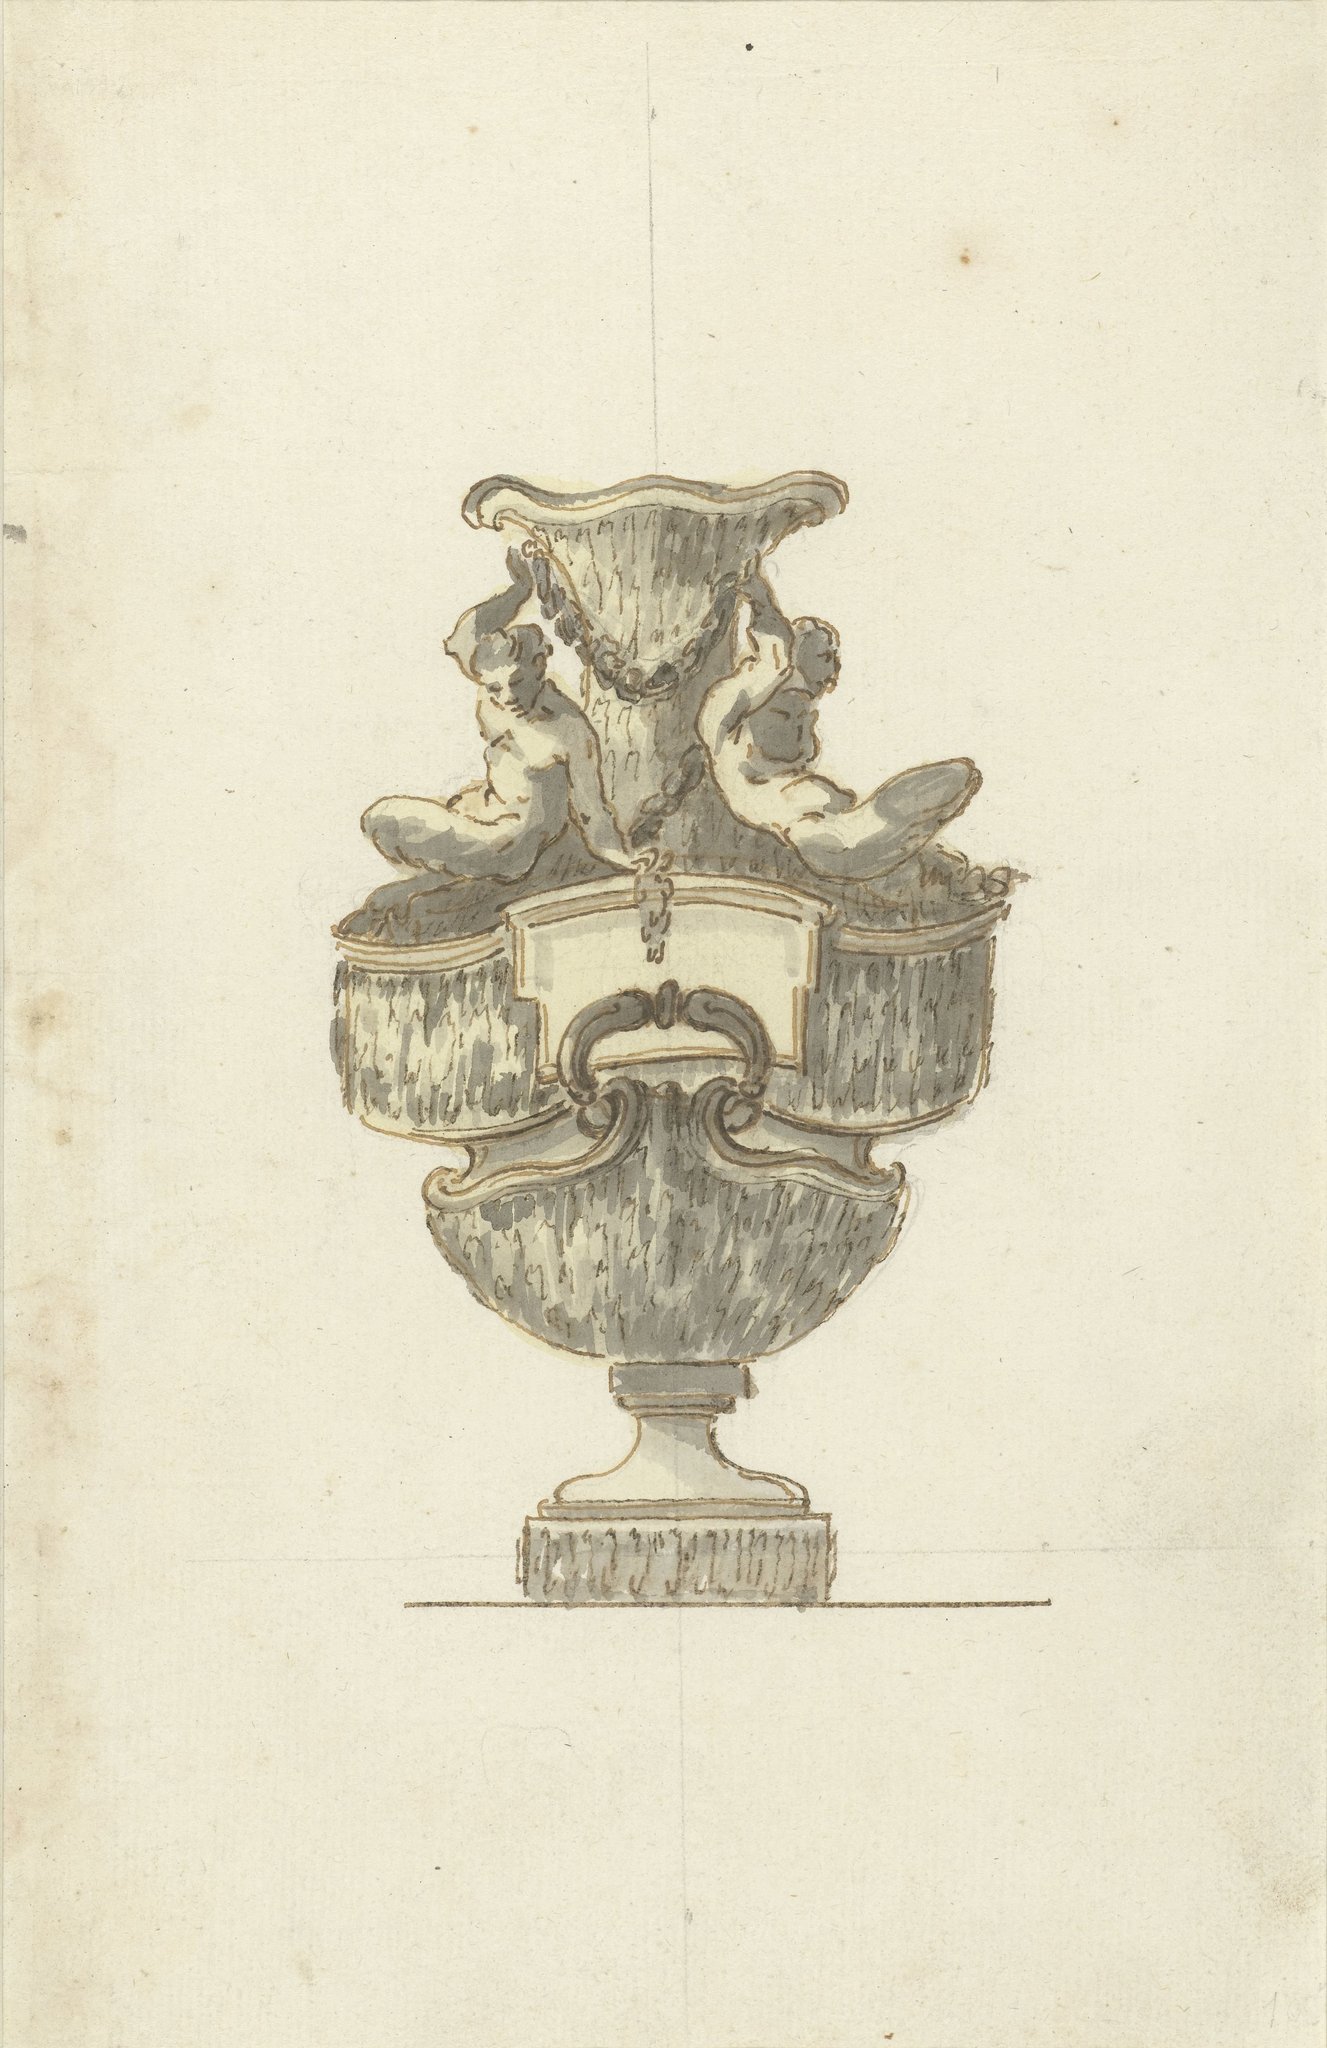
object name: drawing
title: Monumentale siervaas met twee faunen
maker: Anonymous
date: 1700-1800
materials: ink, paper, watercolor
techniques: brush, pen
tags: containers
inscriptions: collector's mark, verso, on the passepartout, lower right: Lugt 2228, inscription, verso, upper centre, pen and brown ink: ‘6.’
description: Monumentale siervaas, met een oor naar de voorzijde gekeerd en twee faunen tegen de hals.